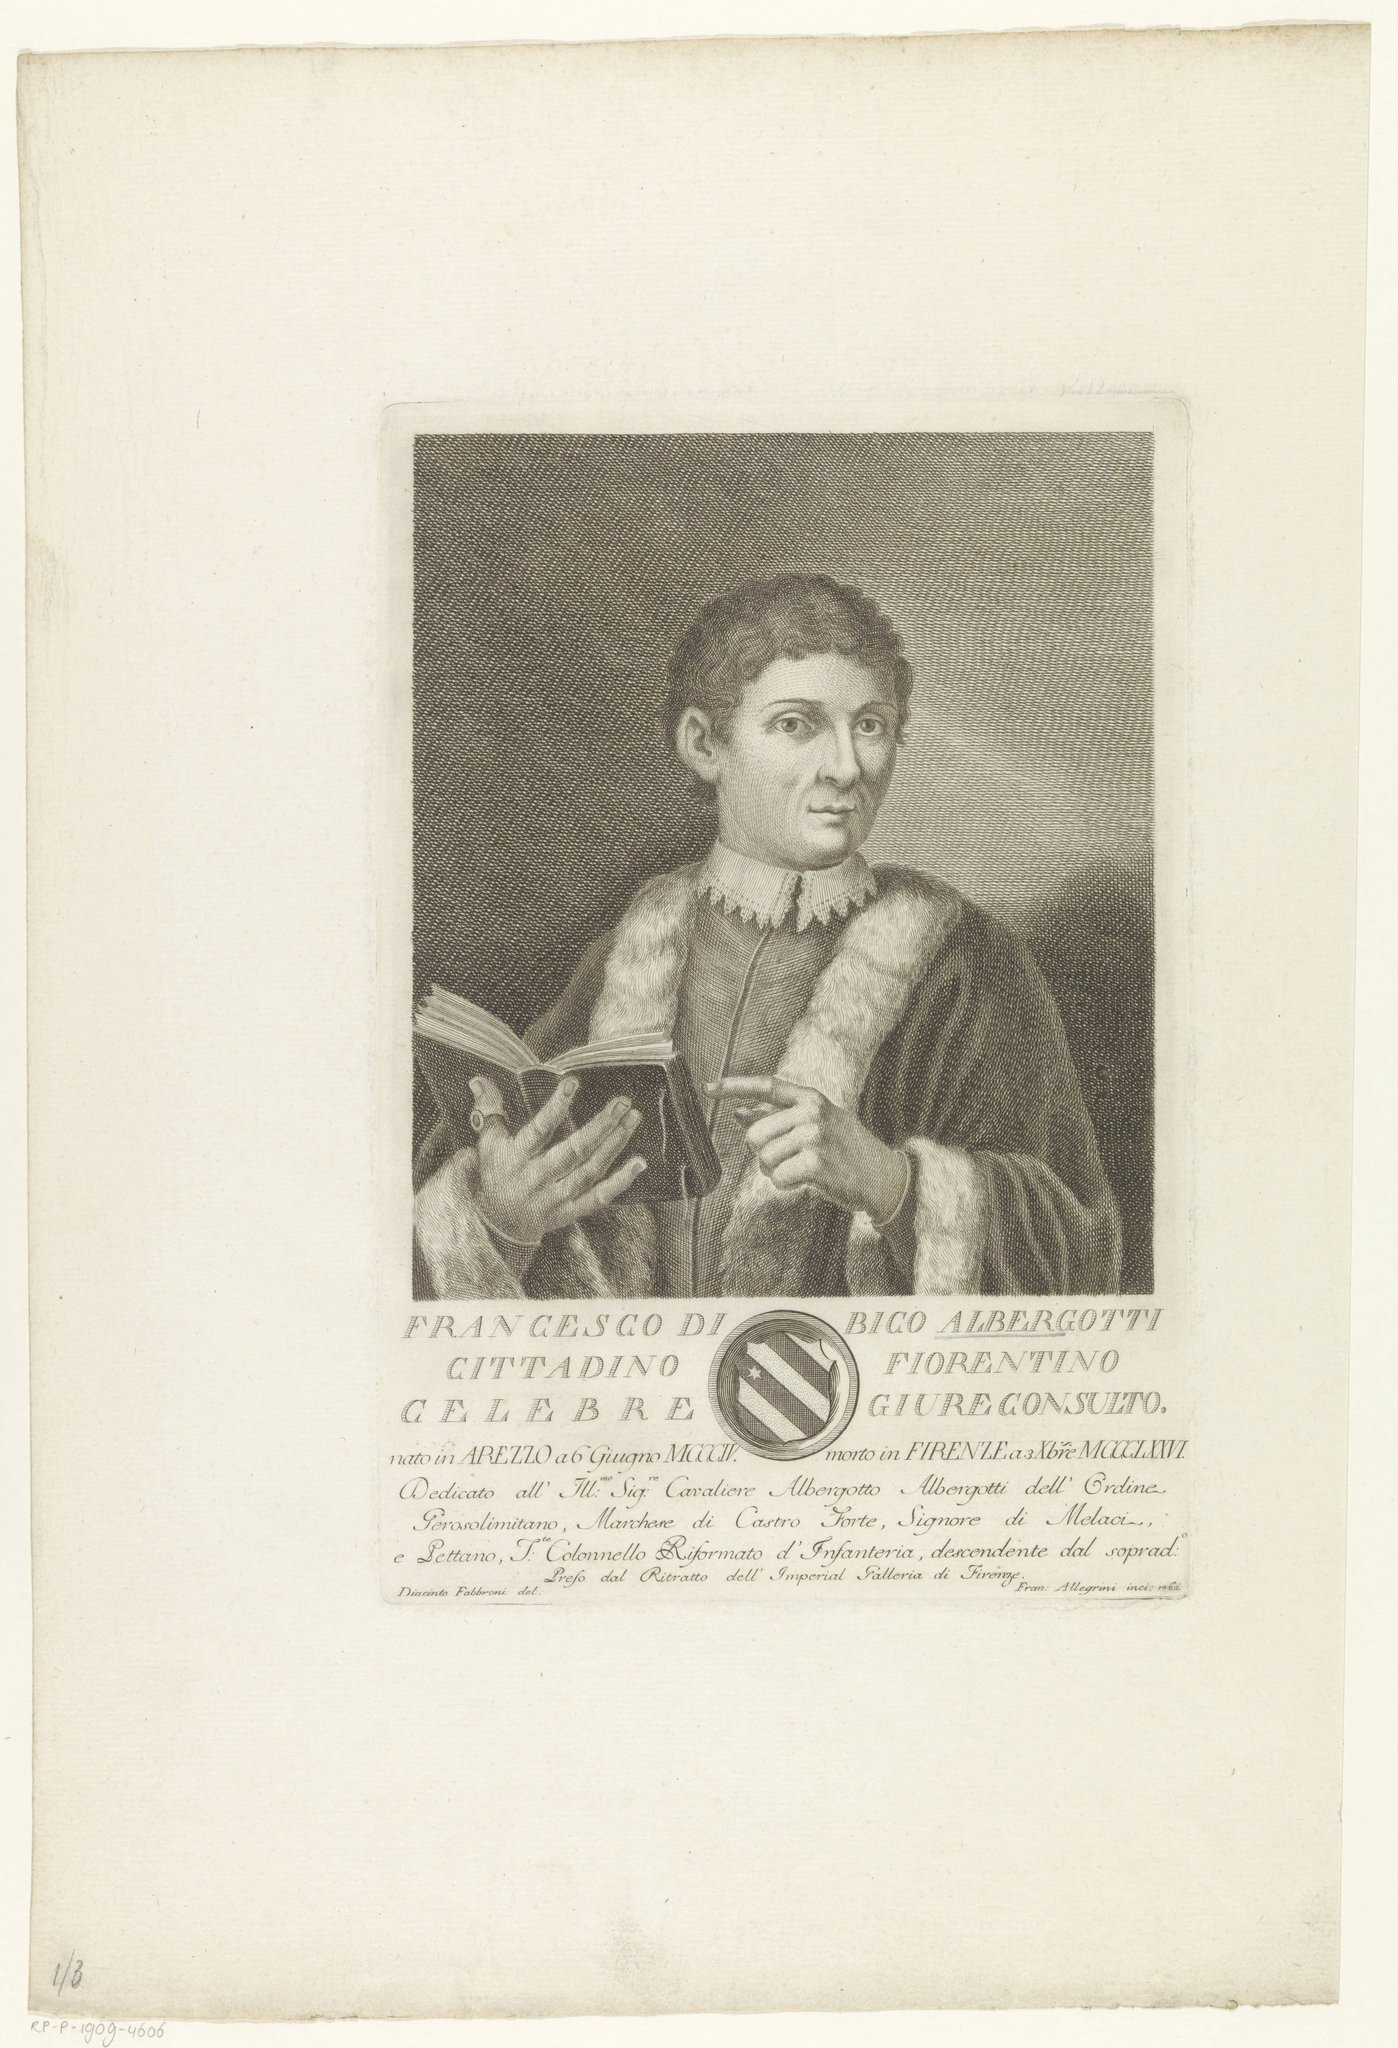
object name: print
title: Portret van Francesco Albergotti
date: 1762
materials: paper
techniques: engraving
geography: italy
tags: historical persons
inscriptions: collector's mark: Lugt 2228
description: Portret van jurist Francesco Albergotti. Hij draagt een met bont gevoerde mantel en houdt in zijn rechterhand een boek. Onder het portret een tekst in het Italiaans en een wapenschild in een cirkelvormig kader.